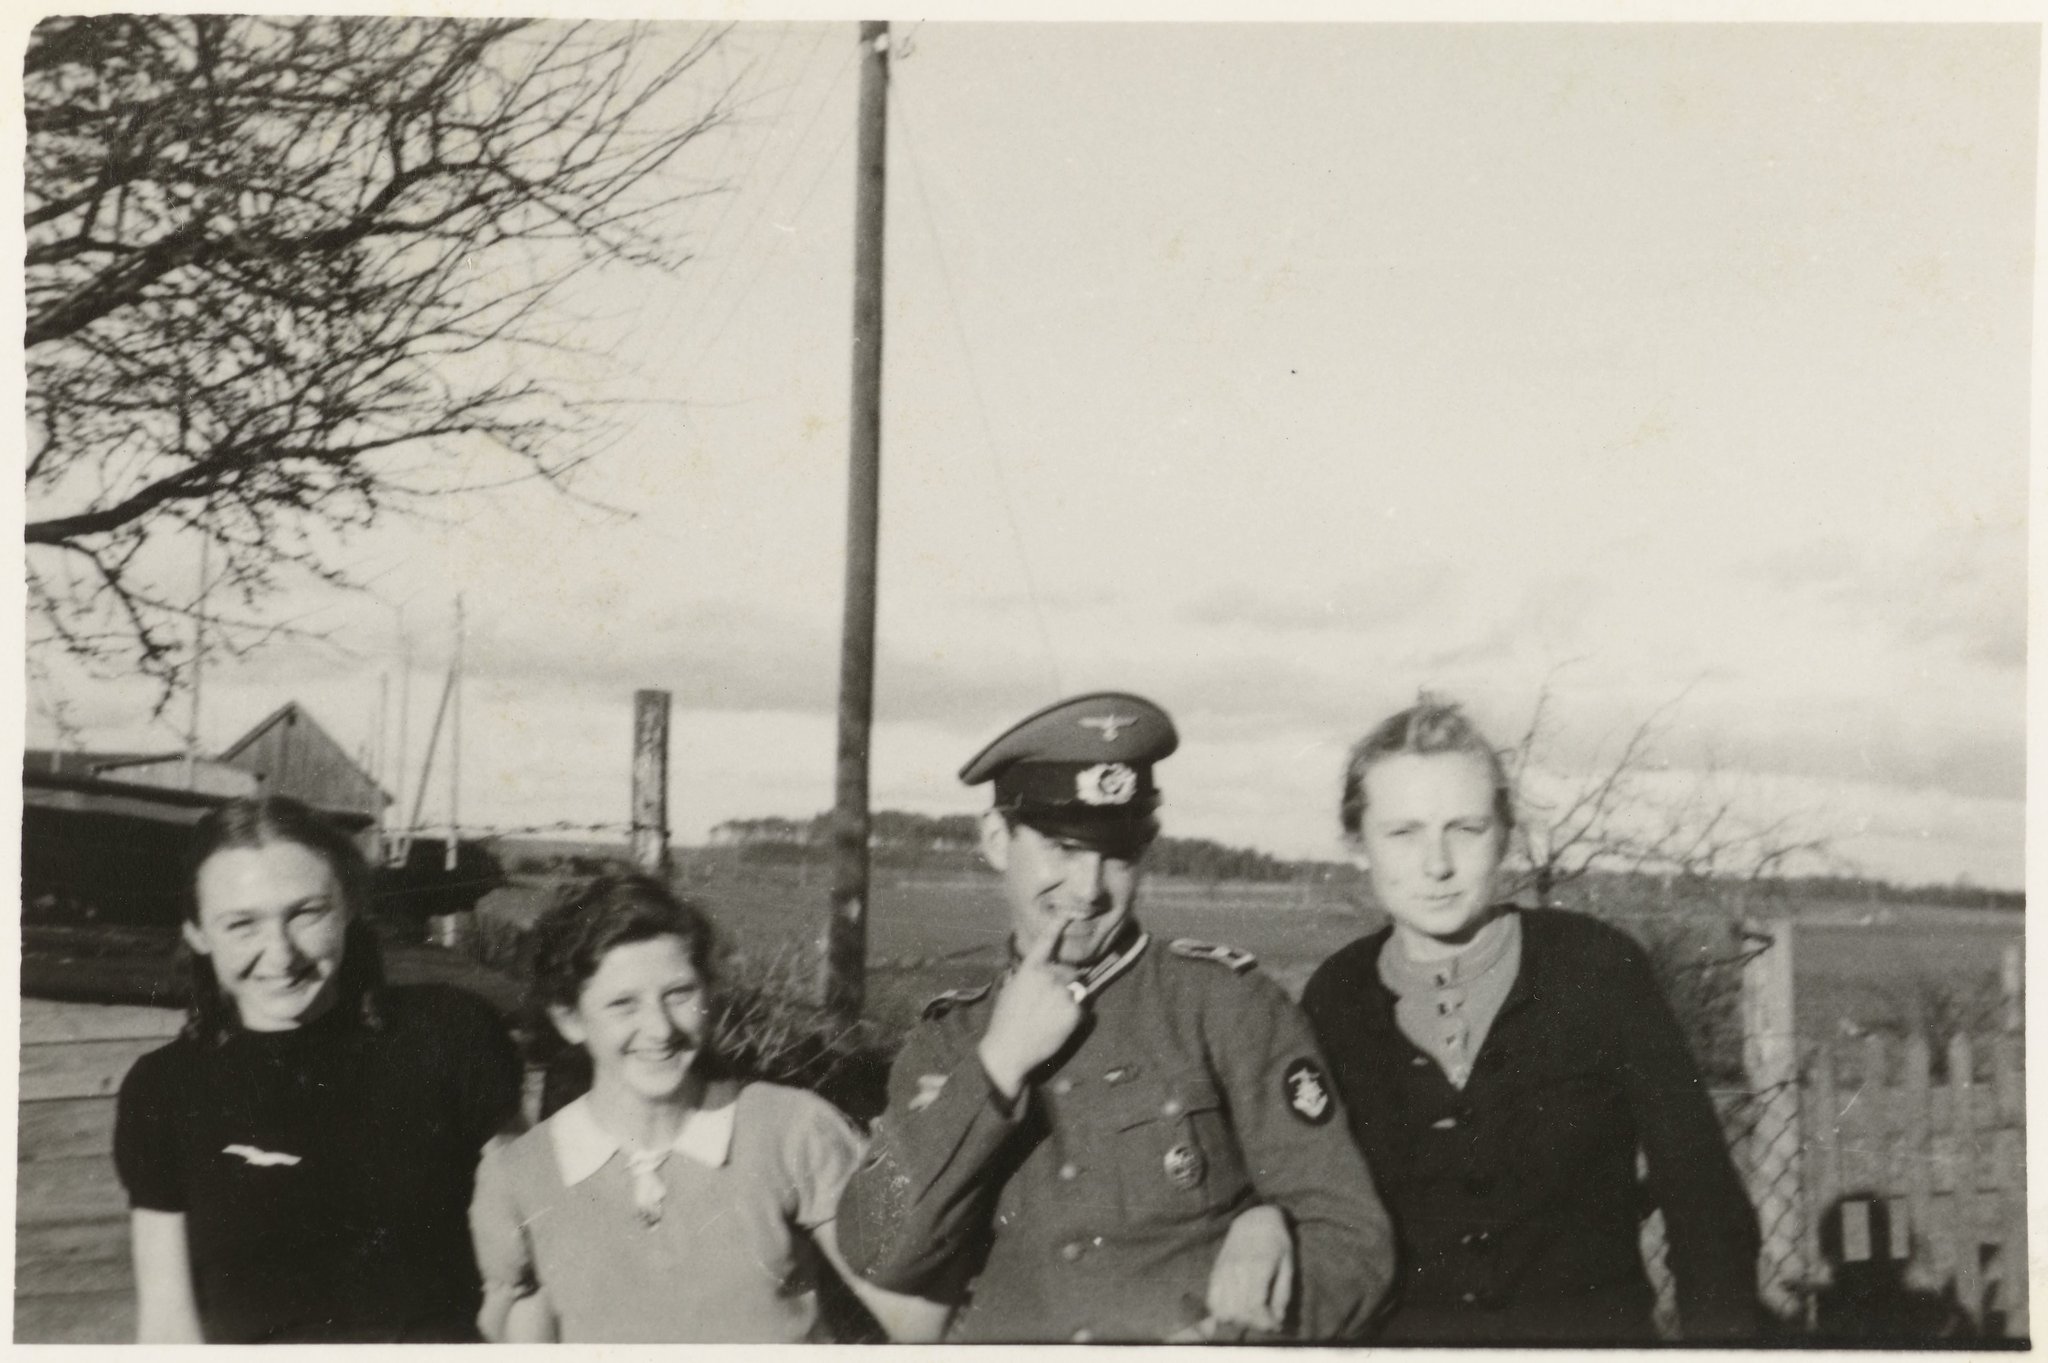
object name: photograph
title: Foto behorend bij album Kriegserinnerungen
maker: Anonymous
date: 1940-1945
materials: photographic support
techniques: gelatin silver print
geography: netherlands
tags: netherlands, germany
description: Foto behorend bij album 'Kriegserinnerungen'.